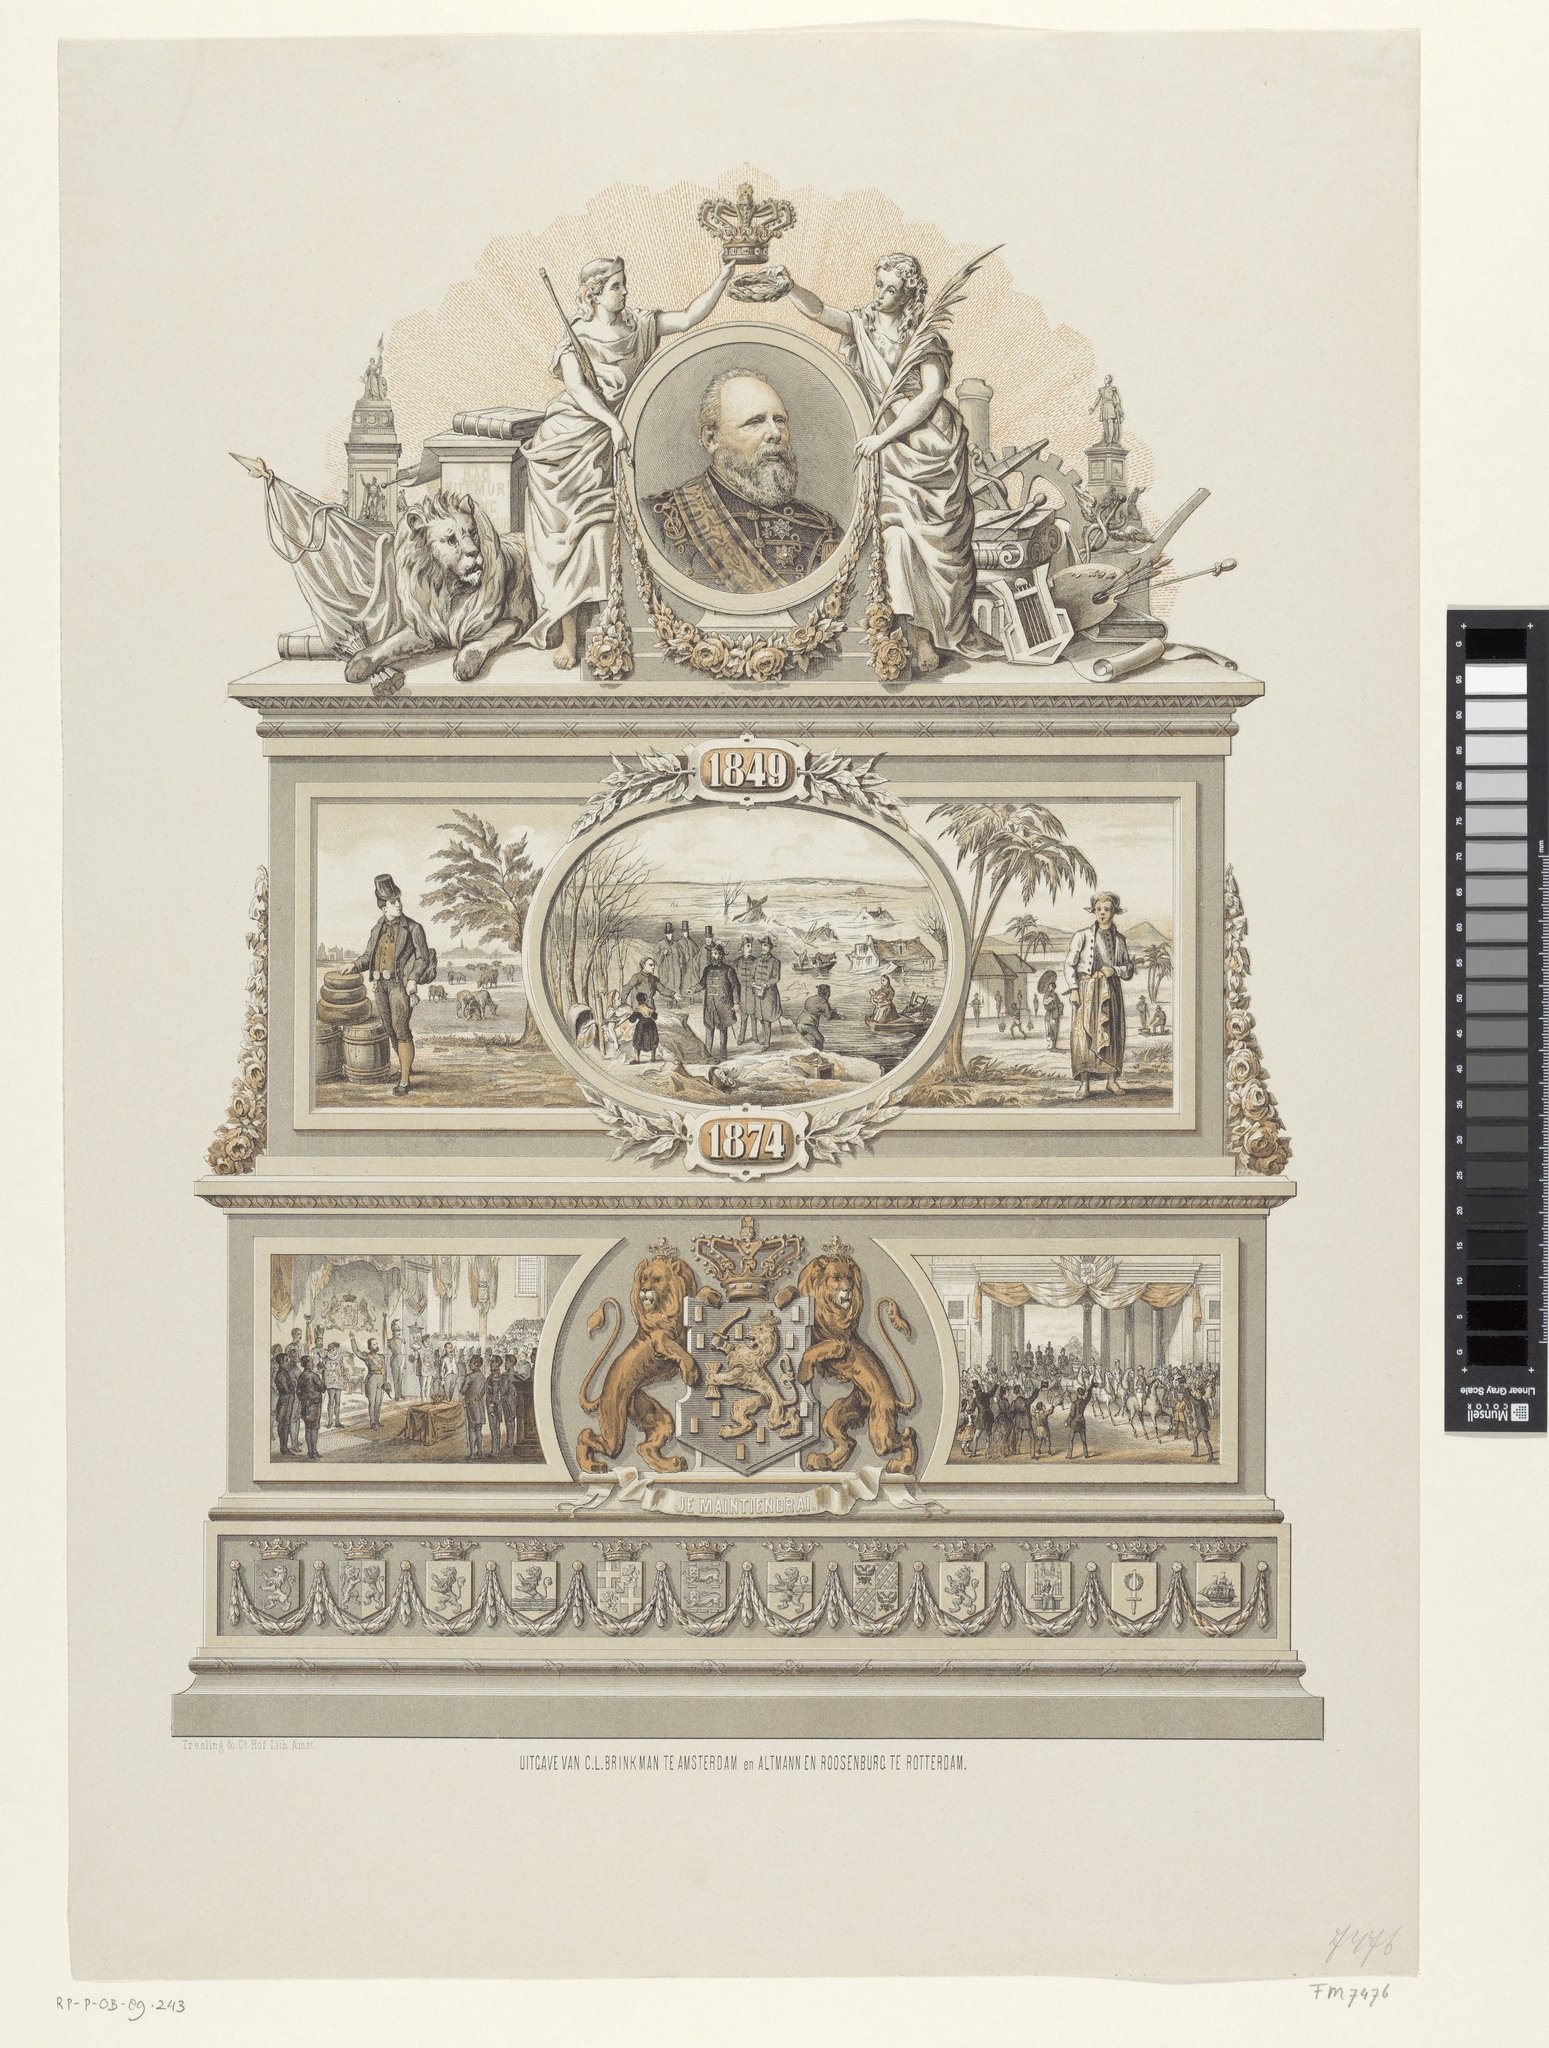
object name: print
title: Gedenkplaat bij het 25-jarige regeringsjubileum van koning Willem III 1849-1874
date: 1874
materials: paper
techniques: lithograph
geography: rotterdam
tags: willem iii (koning der nederlanden), new ruler taking the oath, dutch east indies, the, amsterdam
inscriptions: collector's mark: Lugt 2228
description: Gedenkplaat bij de viering van het 25-jarige regeringsjubileum van koning Willem III, 12 mei 1874. Monument met bovenop een portret van de koning gekroond door Geschiedenis en Vrede. Op het voetstuk een voorstelling van het bezoek van de koning aan het door watersnood getroffen gebied in 1861, links een Nederlandse boer, rechts een Indiër. Daaronder lhet rijkswapen met inks de inhuldiging van de koning in de Nieuwe Kerk te Amsterdam op 12 mei 1849 en rechts zijn intocht te Amsterdam voorafgaand aan de inhuldiging. Onderaan een fries met de provinciewapens.